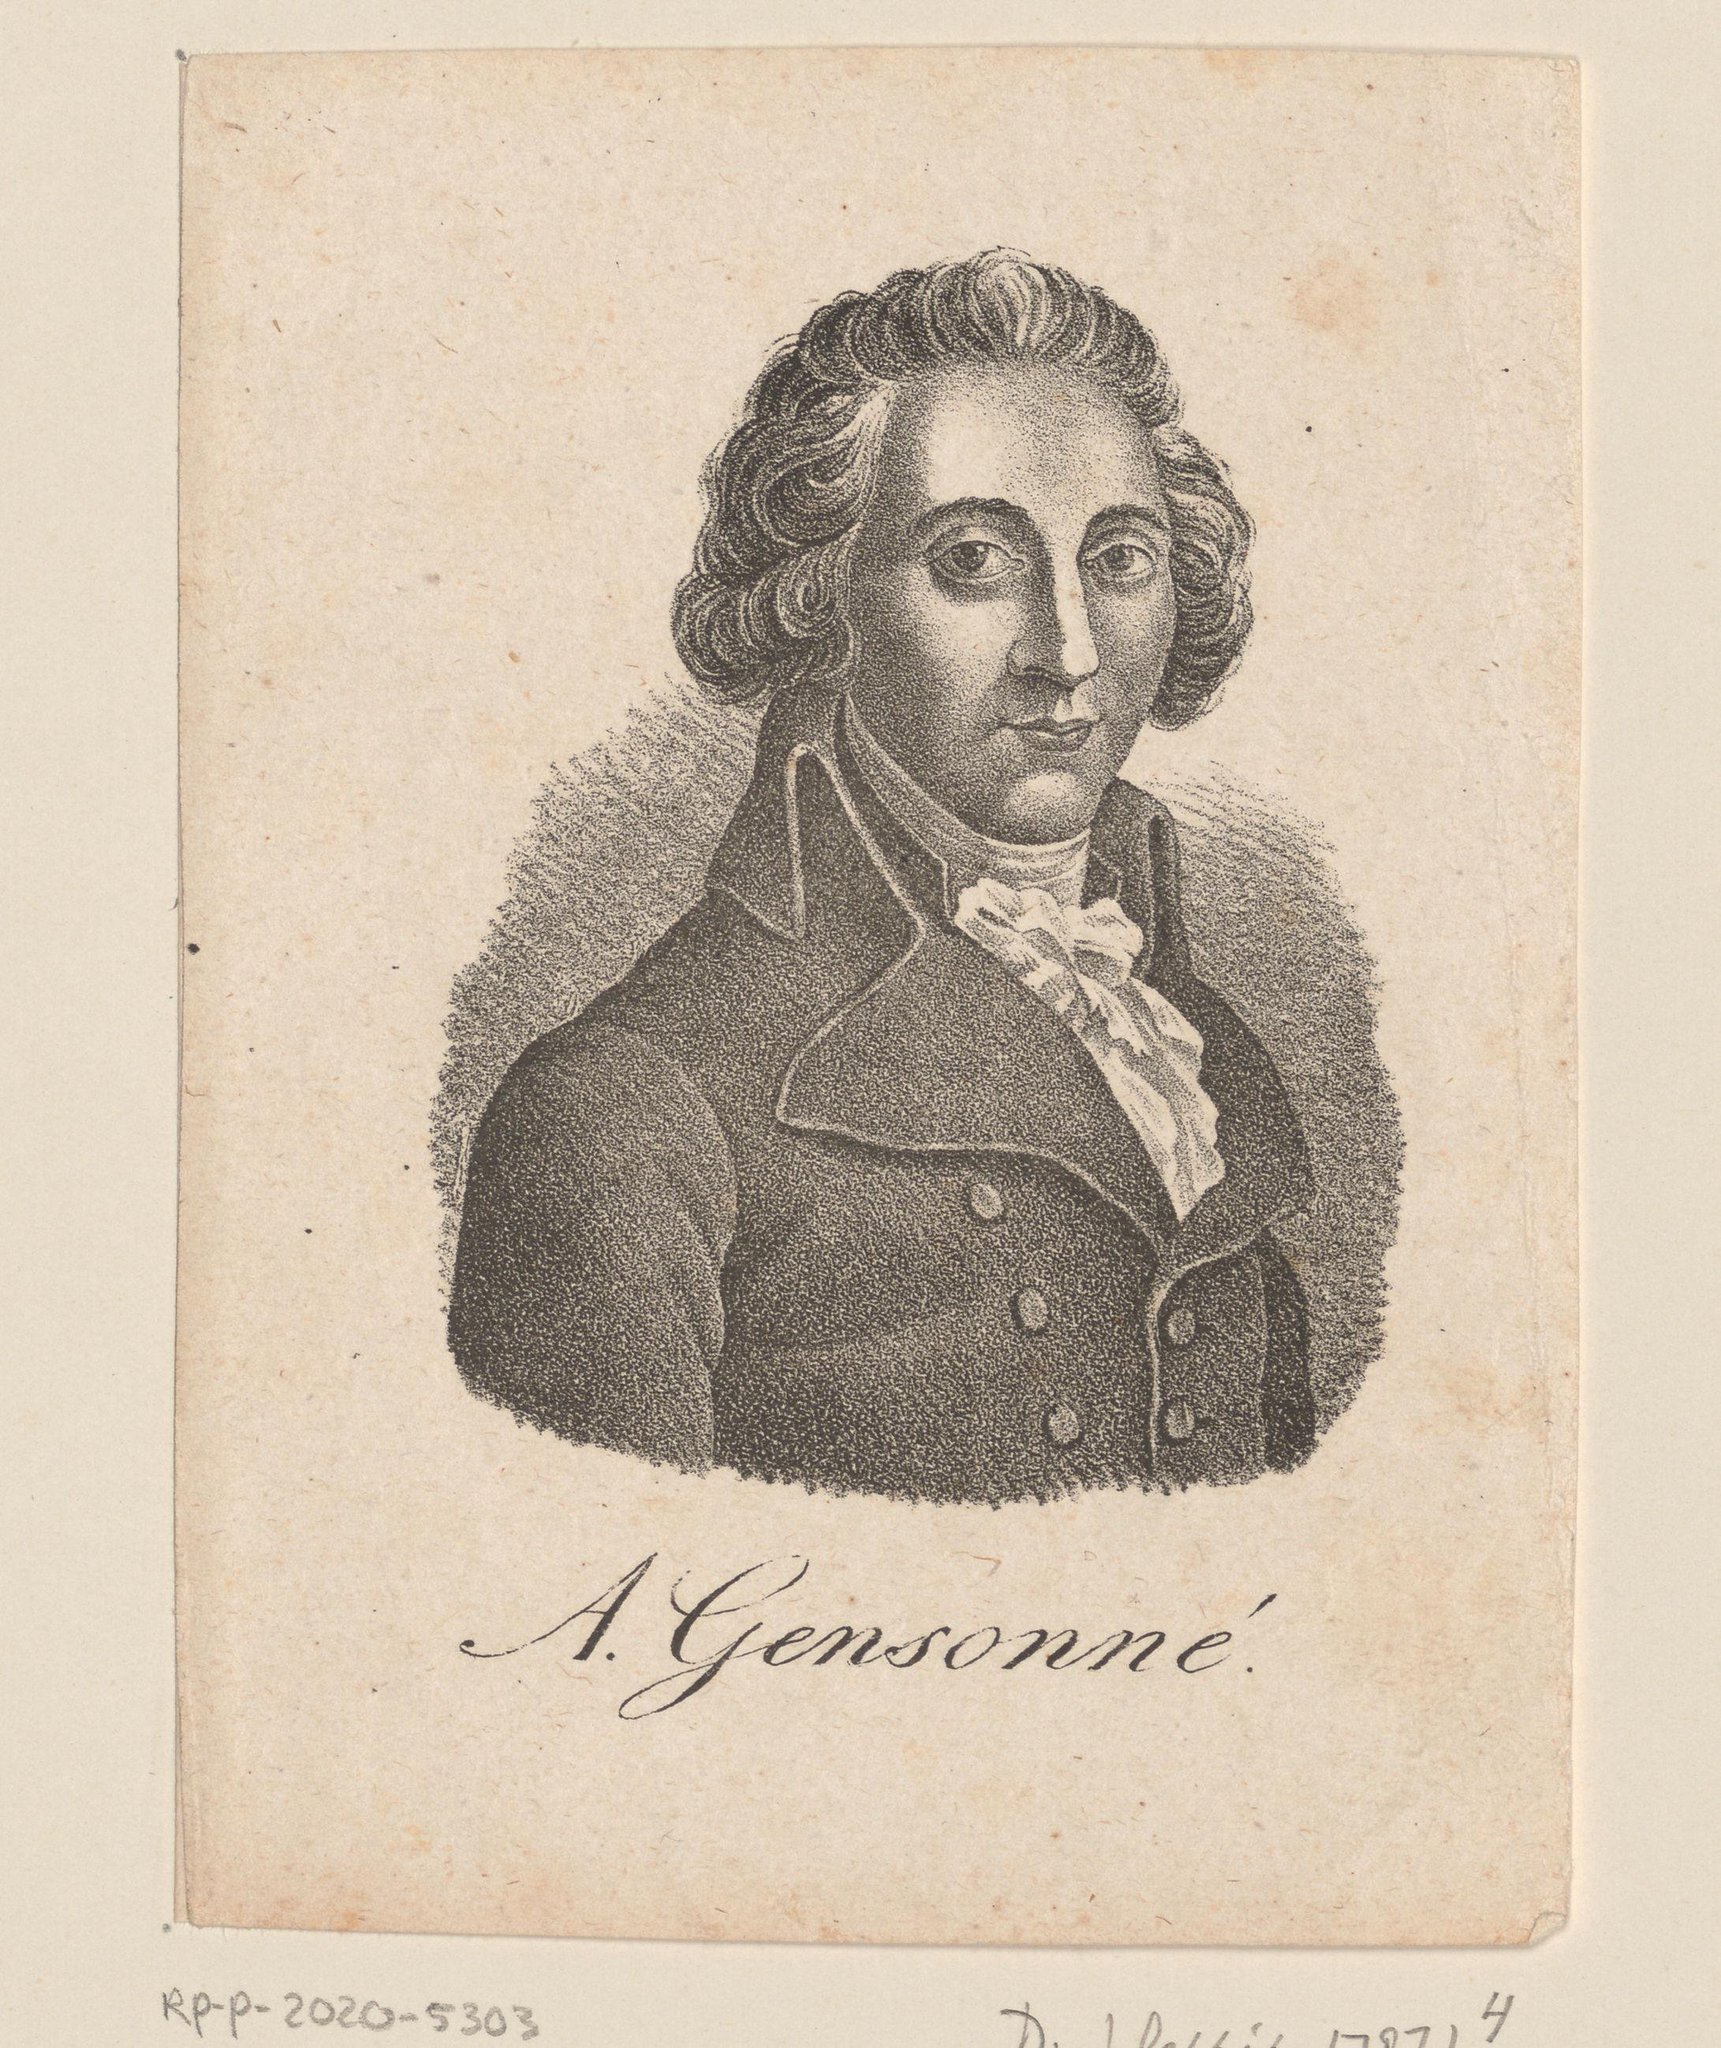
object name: print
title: Portret van Arnaud Gensonné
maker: Anonymous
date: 1798-1850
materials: paper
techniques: lithograph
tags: paris, historical persons, lawyer, attorney at law